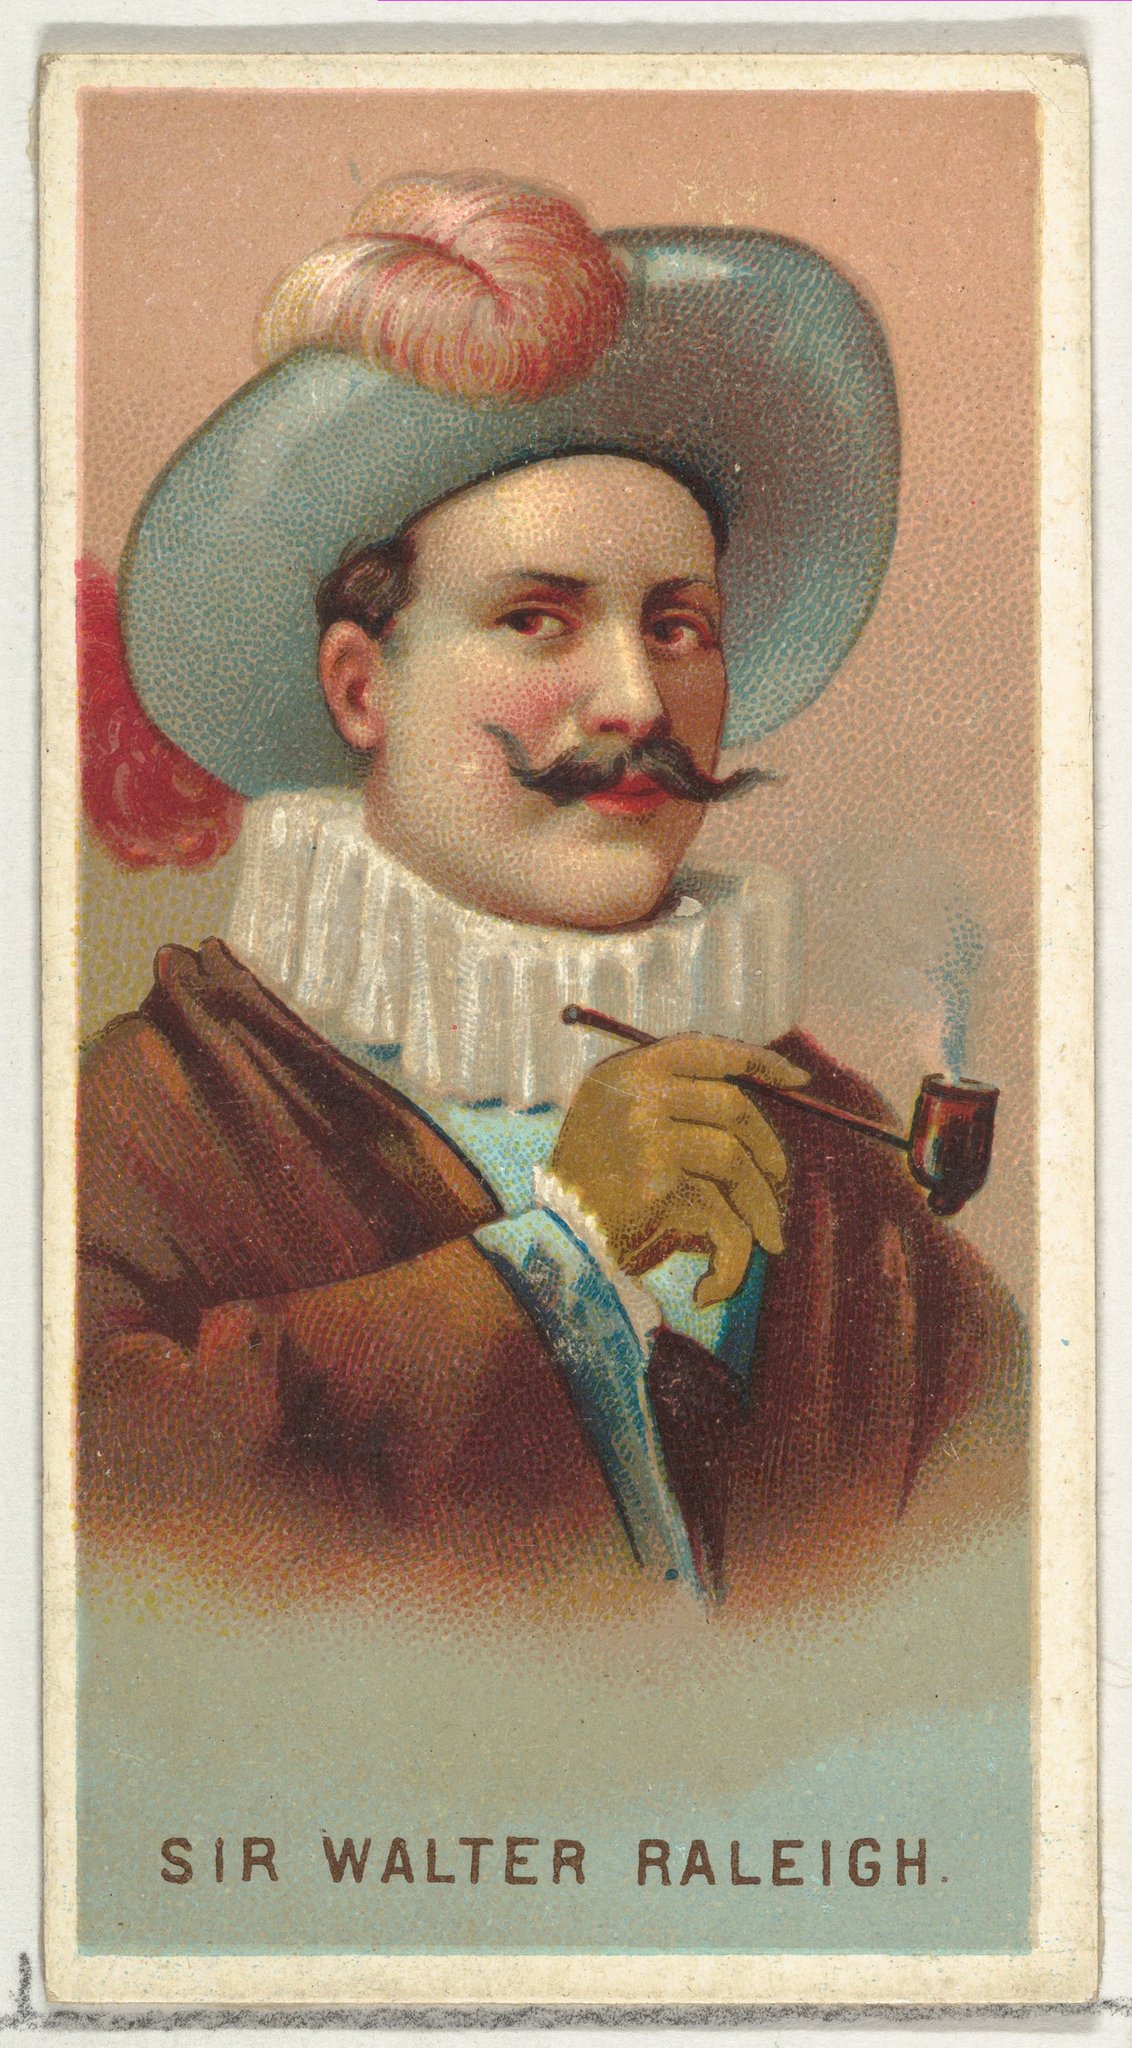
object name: print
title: Sir Walter Raleigh, from World's Smokers series (N33) for Allen & Ginter Cigarettes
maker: allen & ginter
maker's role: publisher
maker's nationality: american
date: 1888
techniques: color lithograph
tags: men,smoking